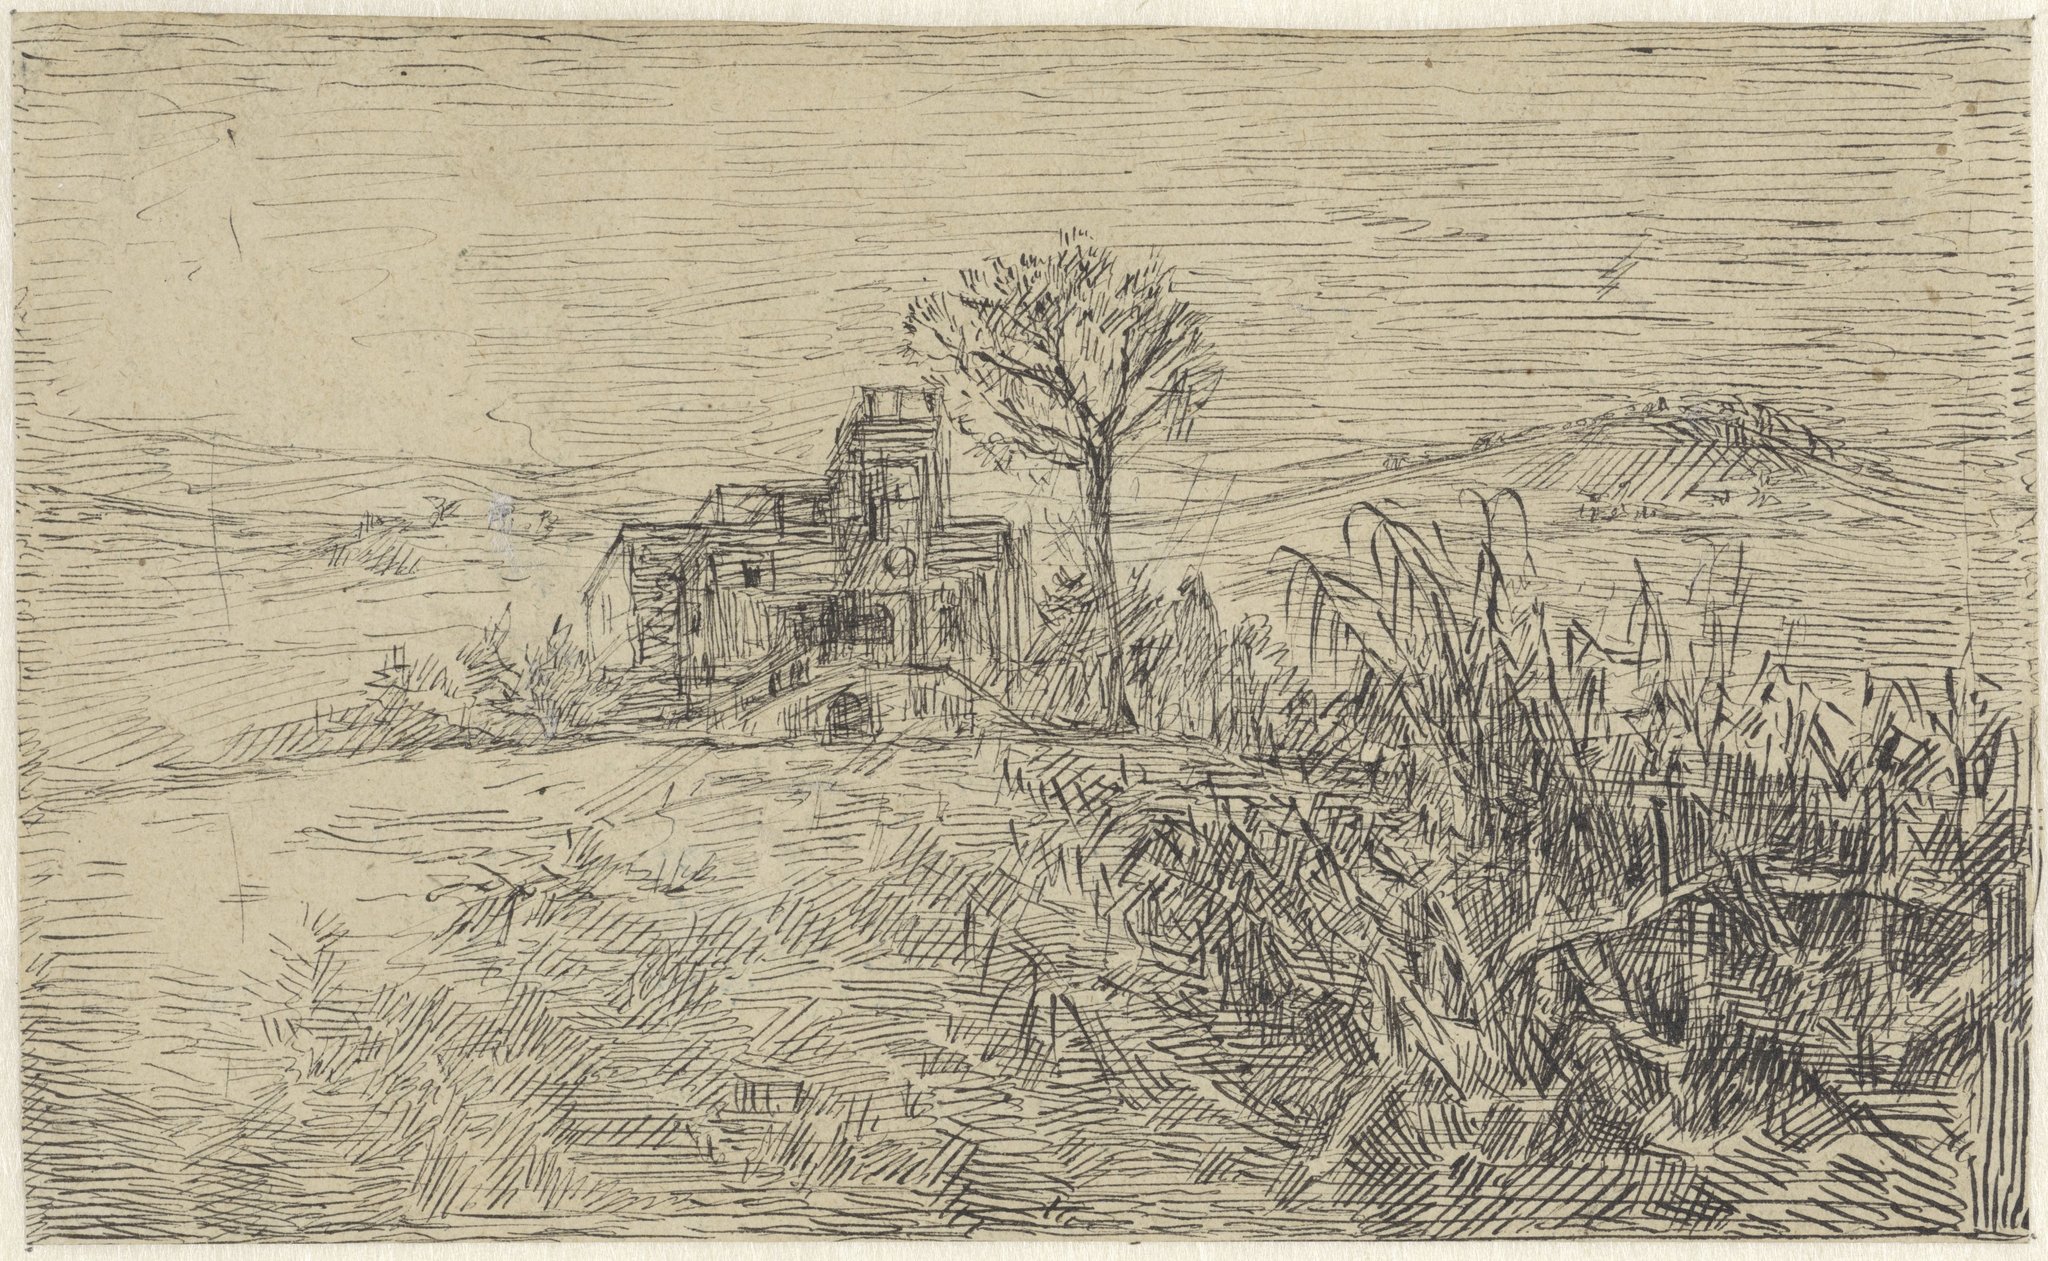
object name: drawing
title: Villa bij Rome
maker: thomas cool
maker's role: draughtsman, painter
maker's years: 1851-1904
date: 1861-1904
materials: ink, paper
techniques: pen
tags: city-view, and landscape with man-made constructions, villa, rome